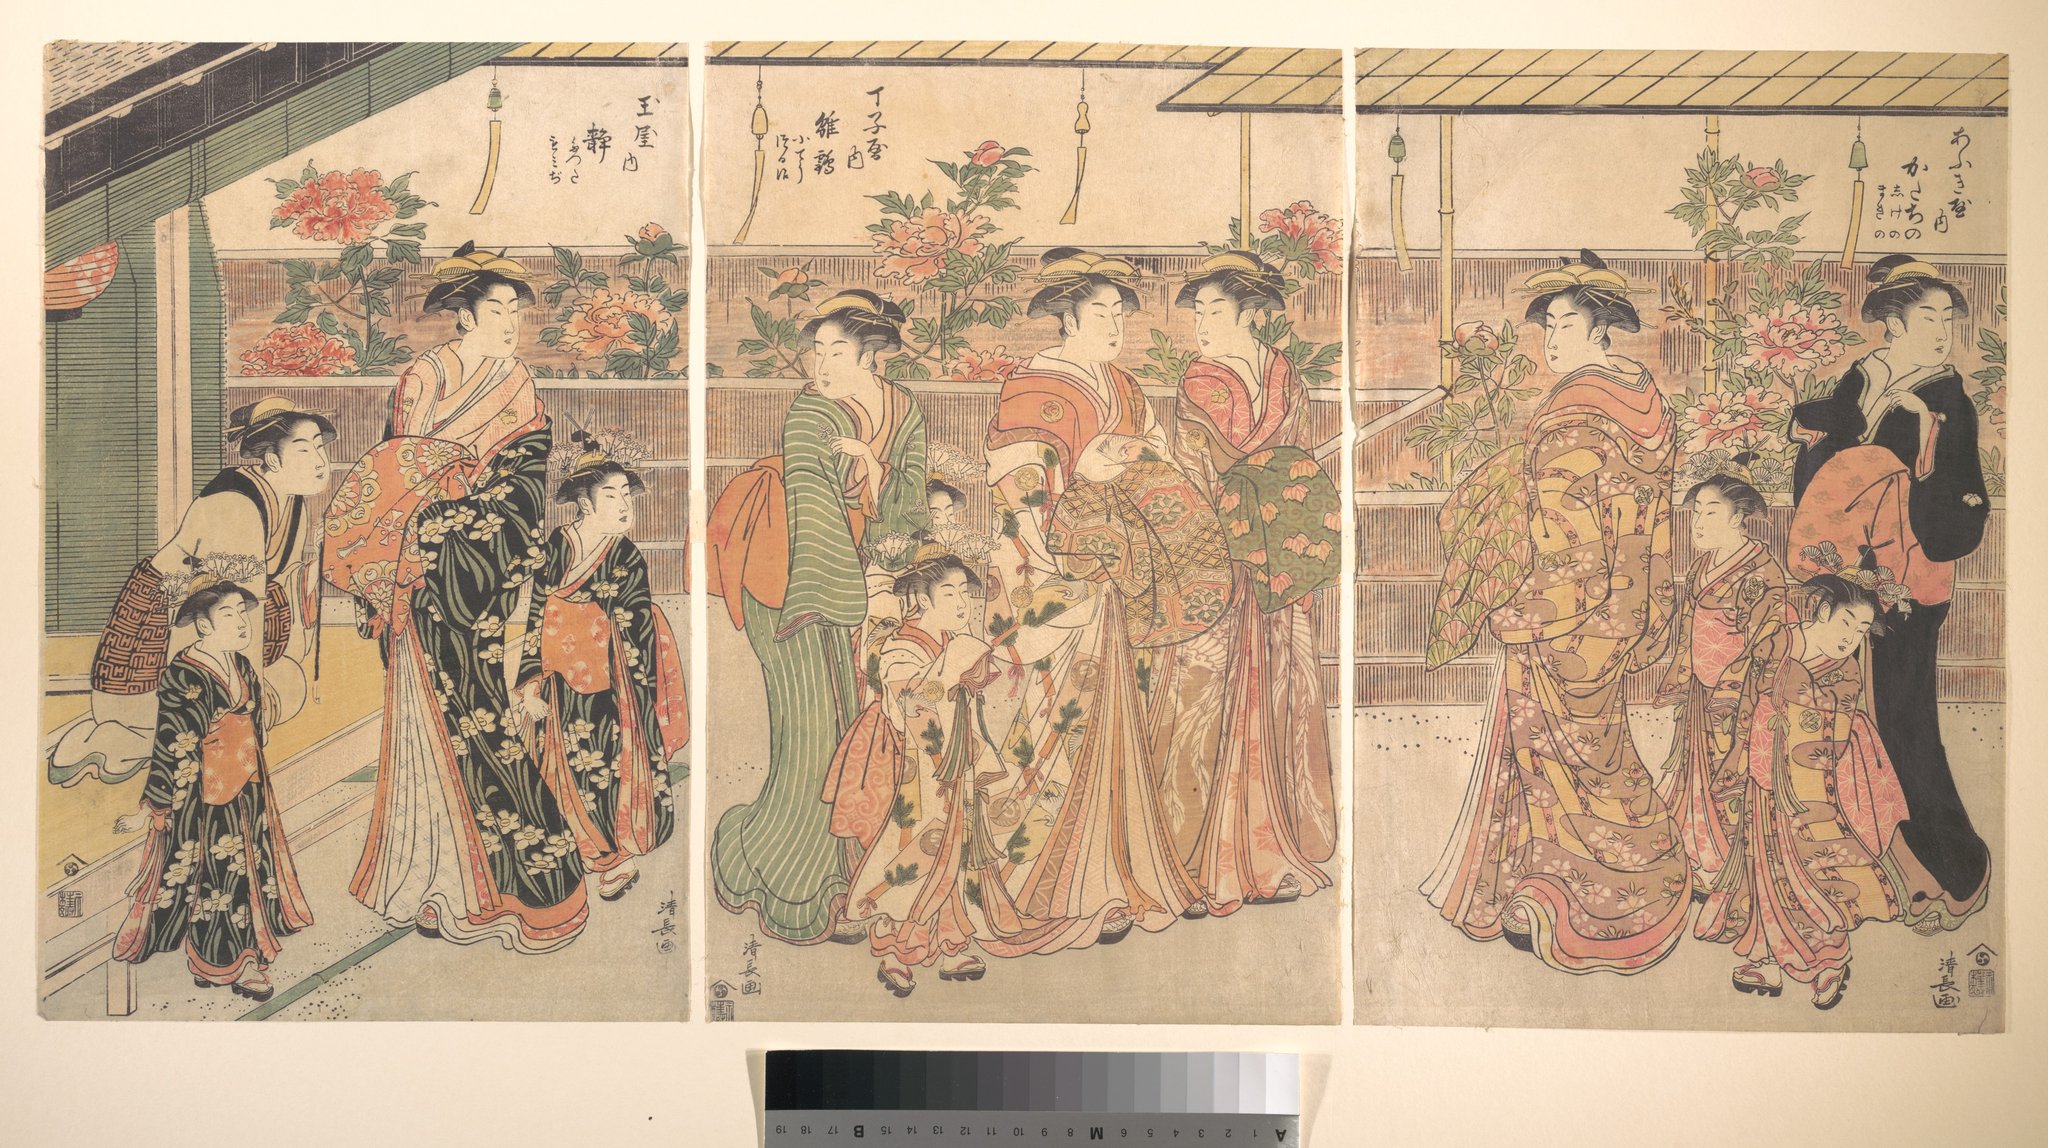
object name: print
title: The Peony Show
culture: japanese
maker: torii kiyonaga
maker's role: artist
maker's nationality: japanese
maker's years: 1752-1815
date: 1790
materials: ink, paper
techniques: woodblock print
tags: girls,women